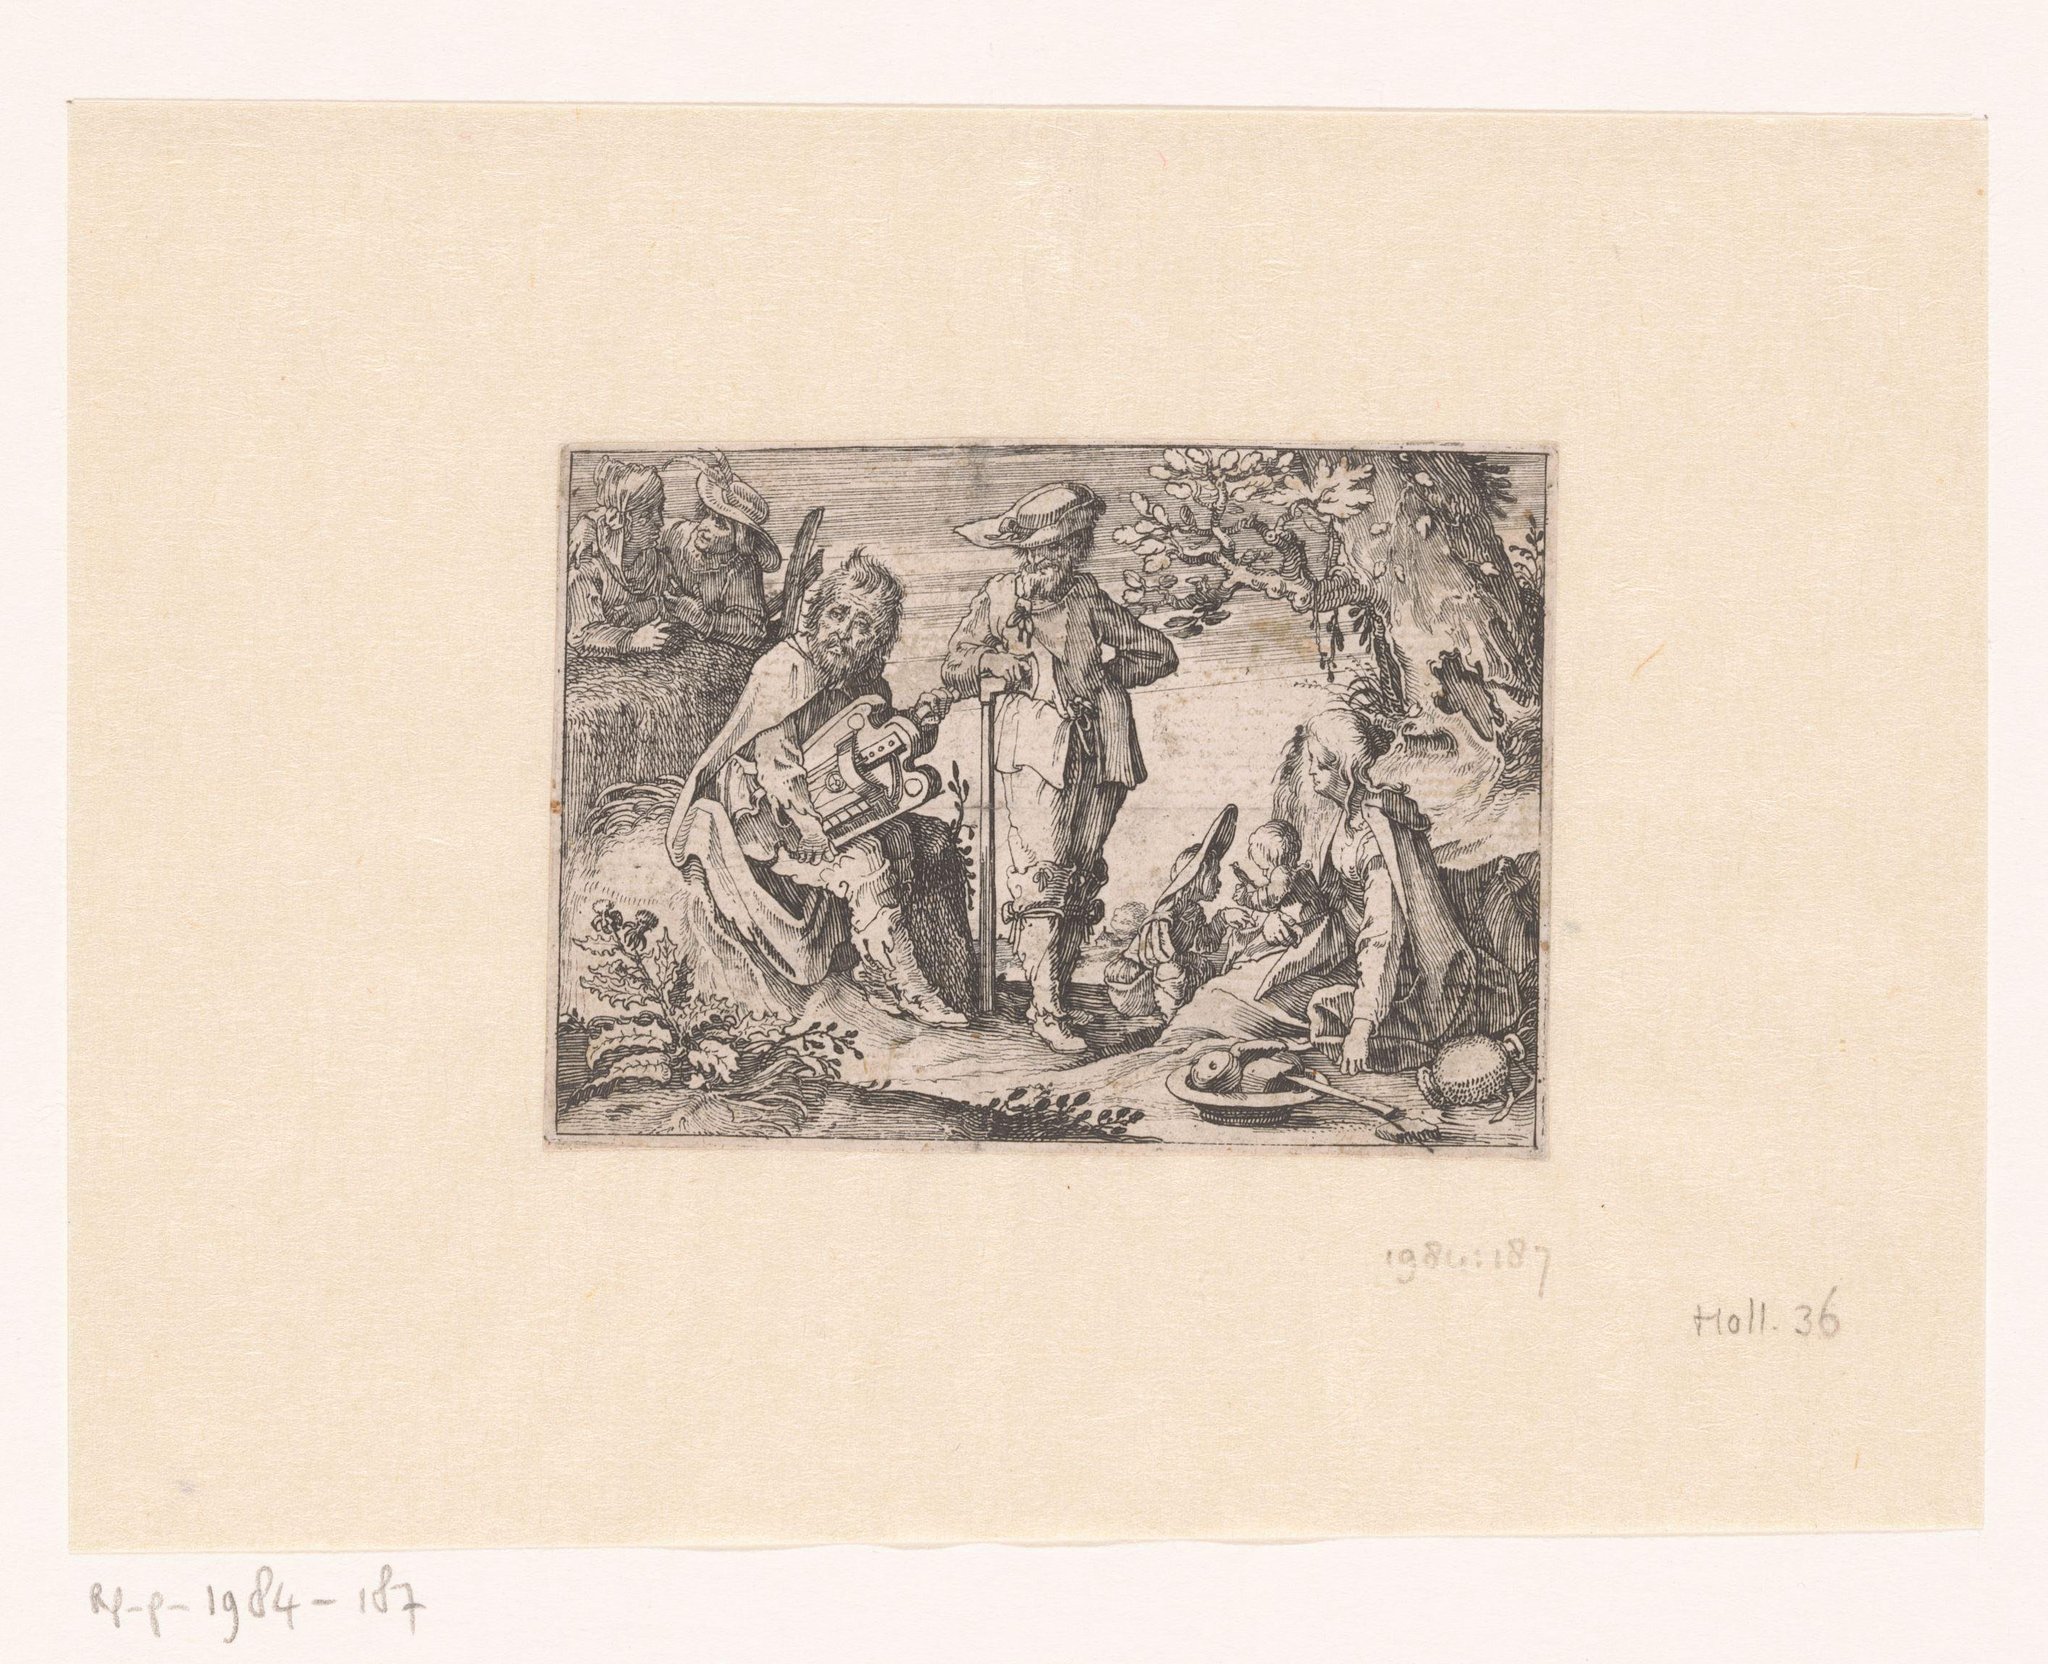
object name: print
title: Houthakker en draailierspeler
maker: rudolph meyer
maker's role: print maker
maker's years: 1605-1638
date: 1615-1638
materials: paper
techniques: etching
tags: one person playing wind instrument - cc - out of doors, beggar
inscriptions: collector's mark: Lugt 2228, collector's mark: Lugt 2233